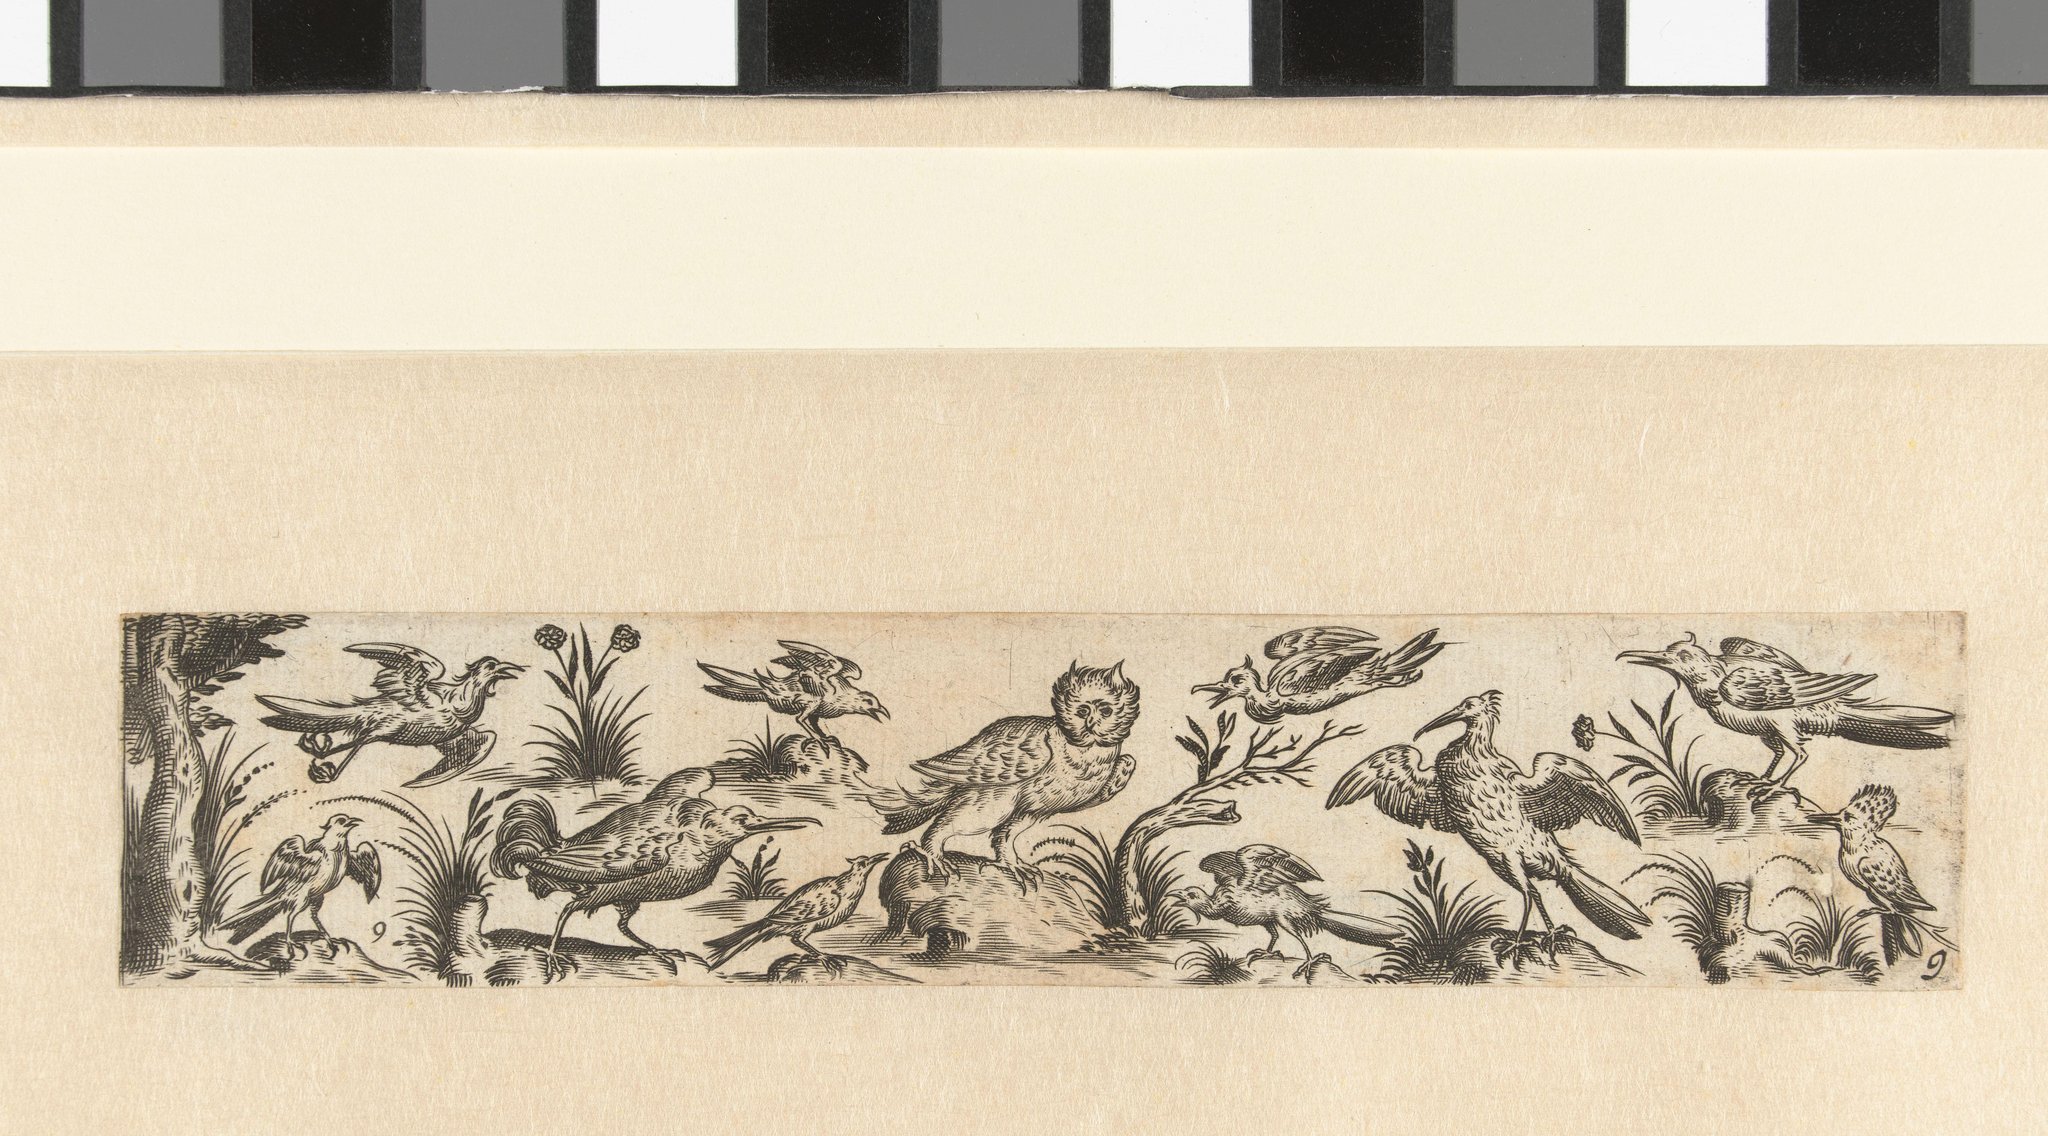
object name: print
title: Friezen met vogels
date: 1631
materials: paper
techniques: engraving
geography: netherlands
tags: birds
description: In het midden staat een uil, rechtsonder zit een hop. Blad 9 uit serie van 12 genummerde bladen.